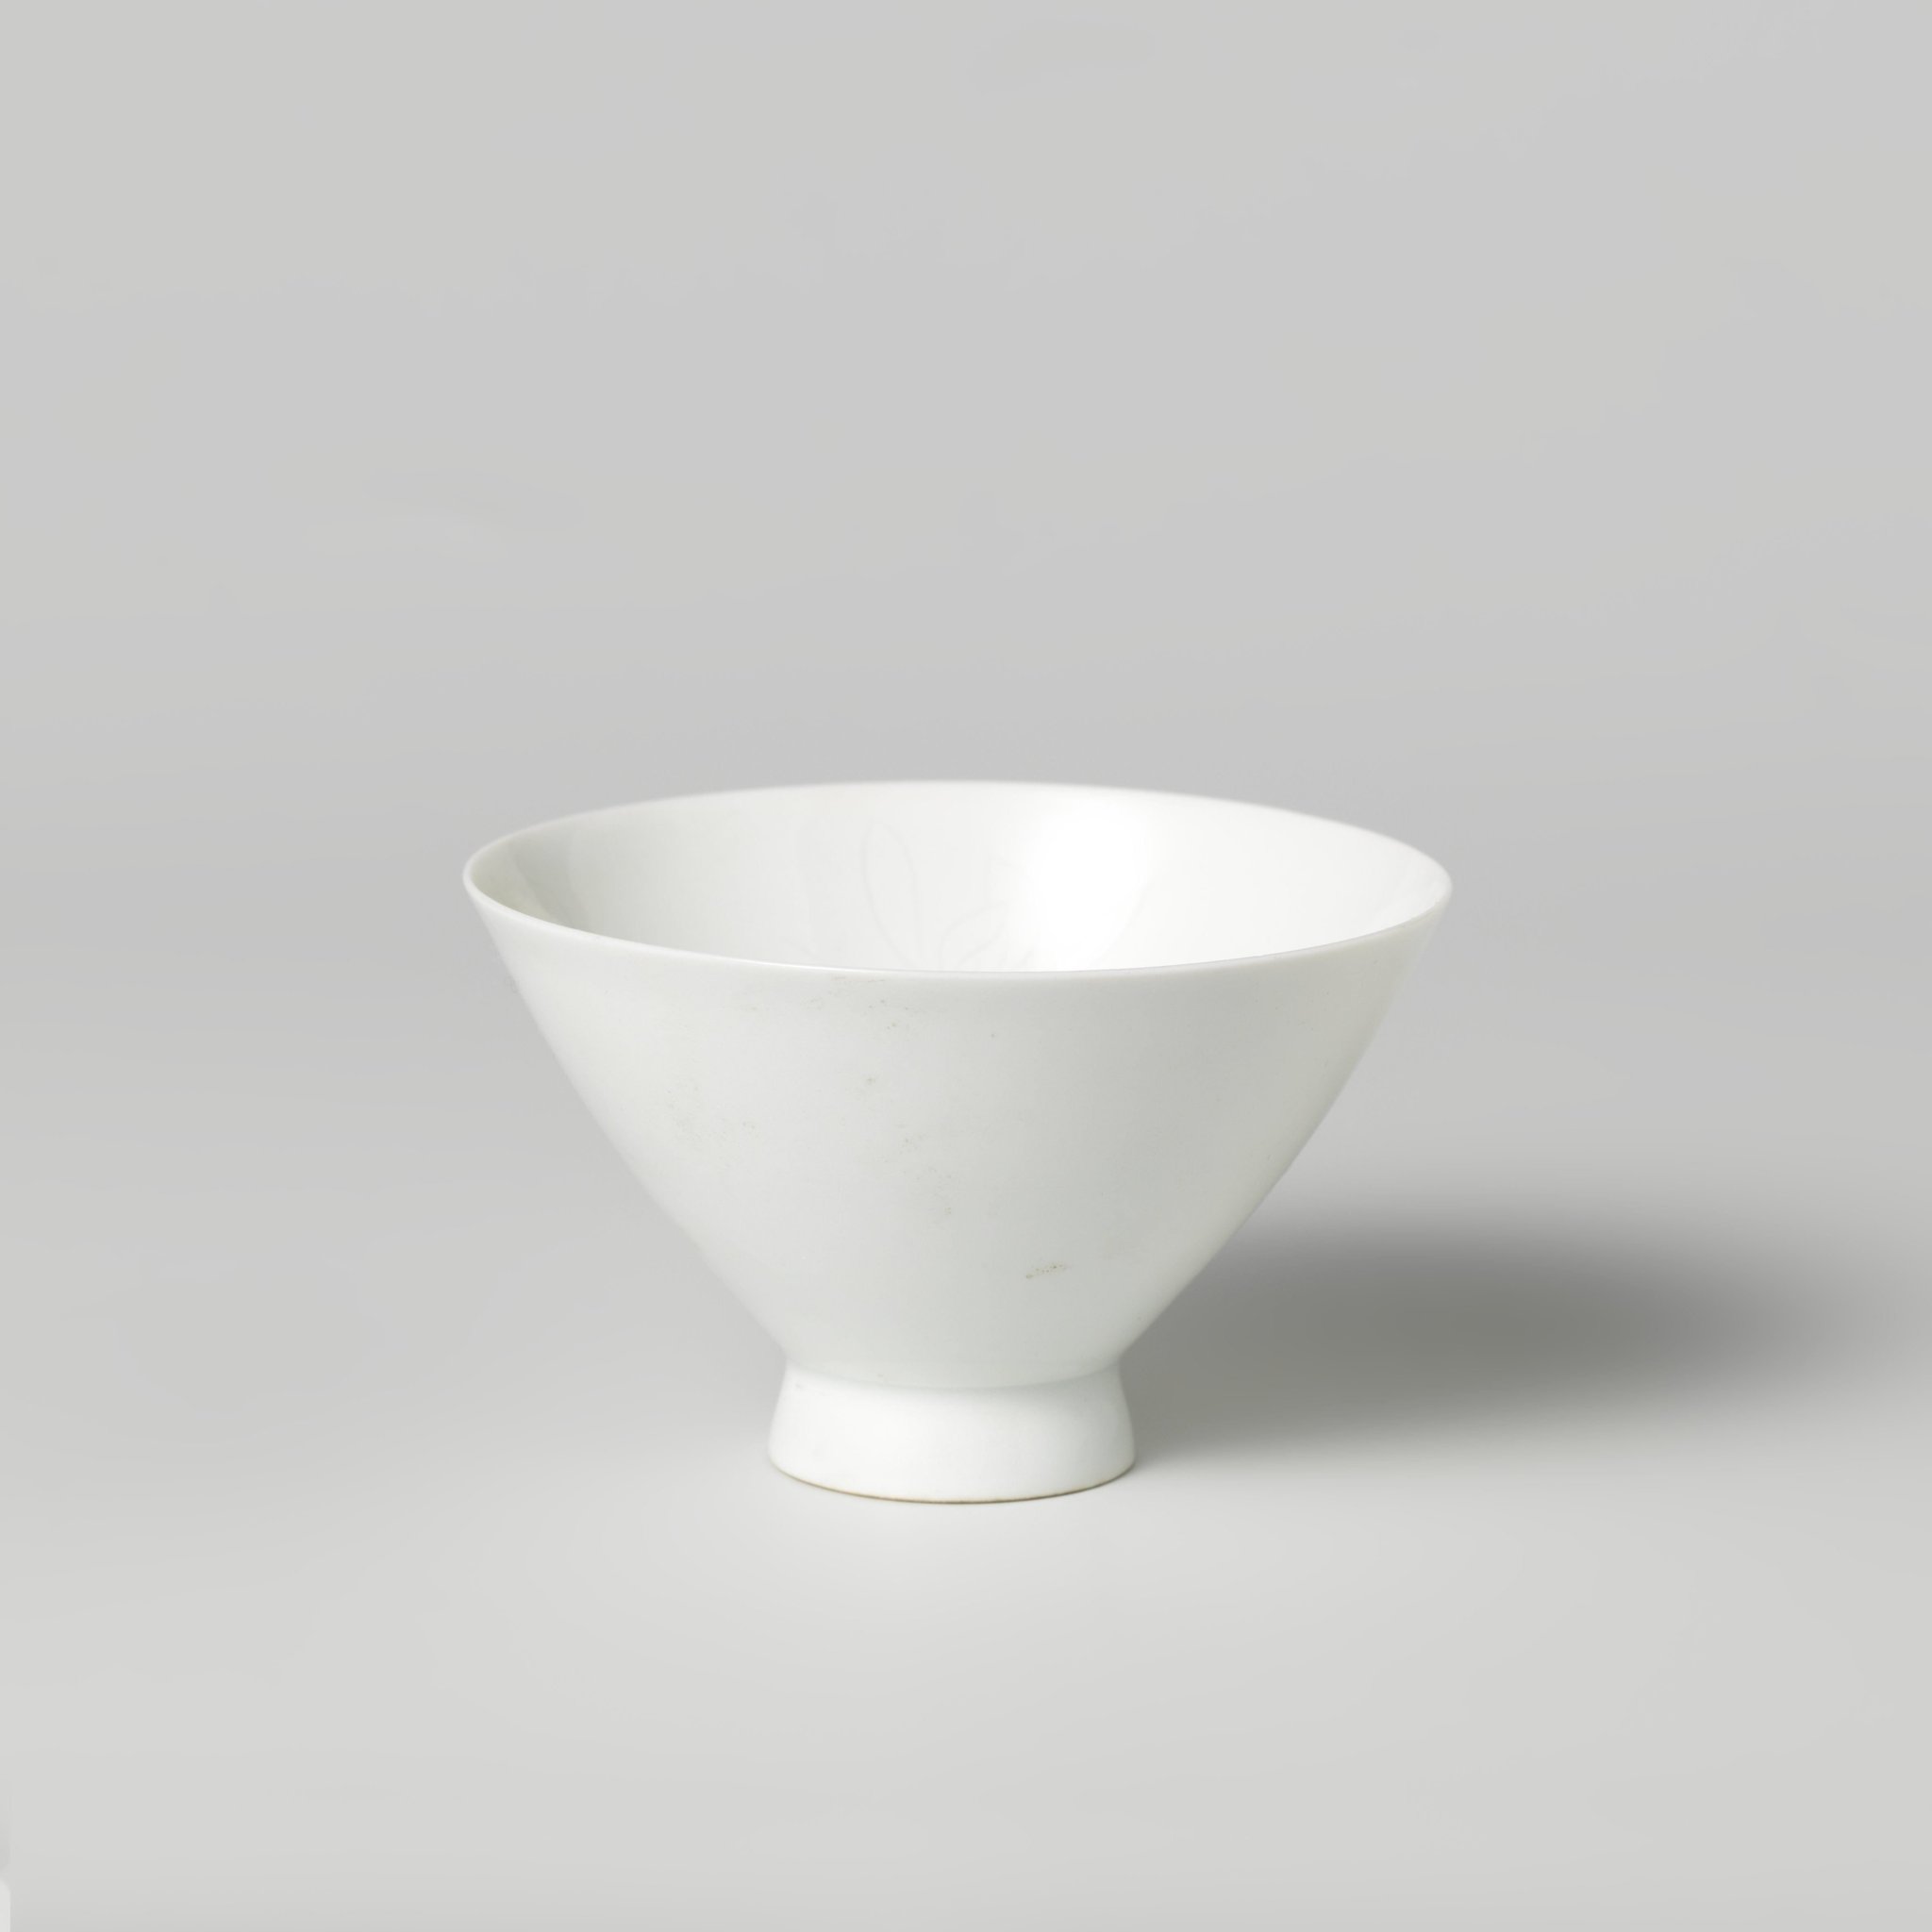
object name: kop en schotel, kop en schotel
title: Cup with incised flower heads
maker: Anonymous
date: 1800-1849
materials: glaze, porcelain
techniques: engraving, firing, turning, vitrification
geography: dehua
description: Kop van porselein, bedekt met een doorschijnend wit glazuur. Conisch gevormde kop met aan de binnenzijde vier ingegrifte bloemen. Blanc de Chine.